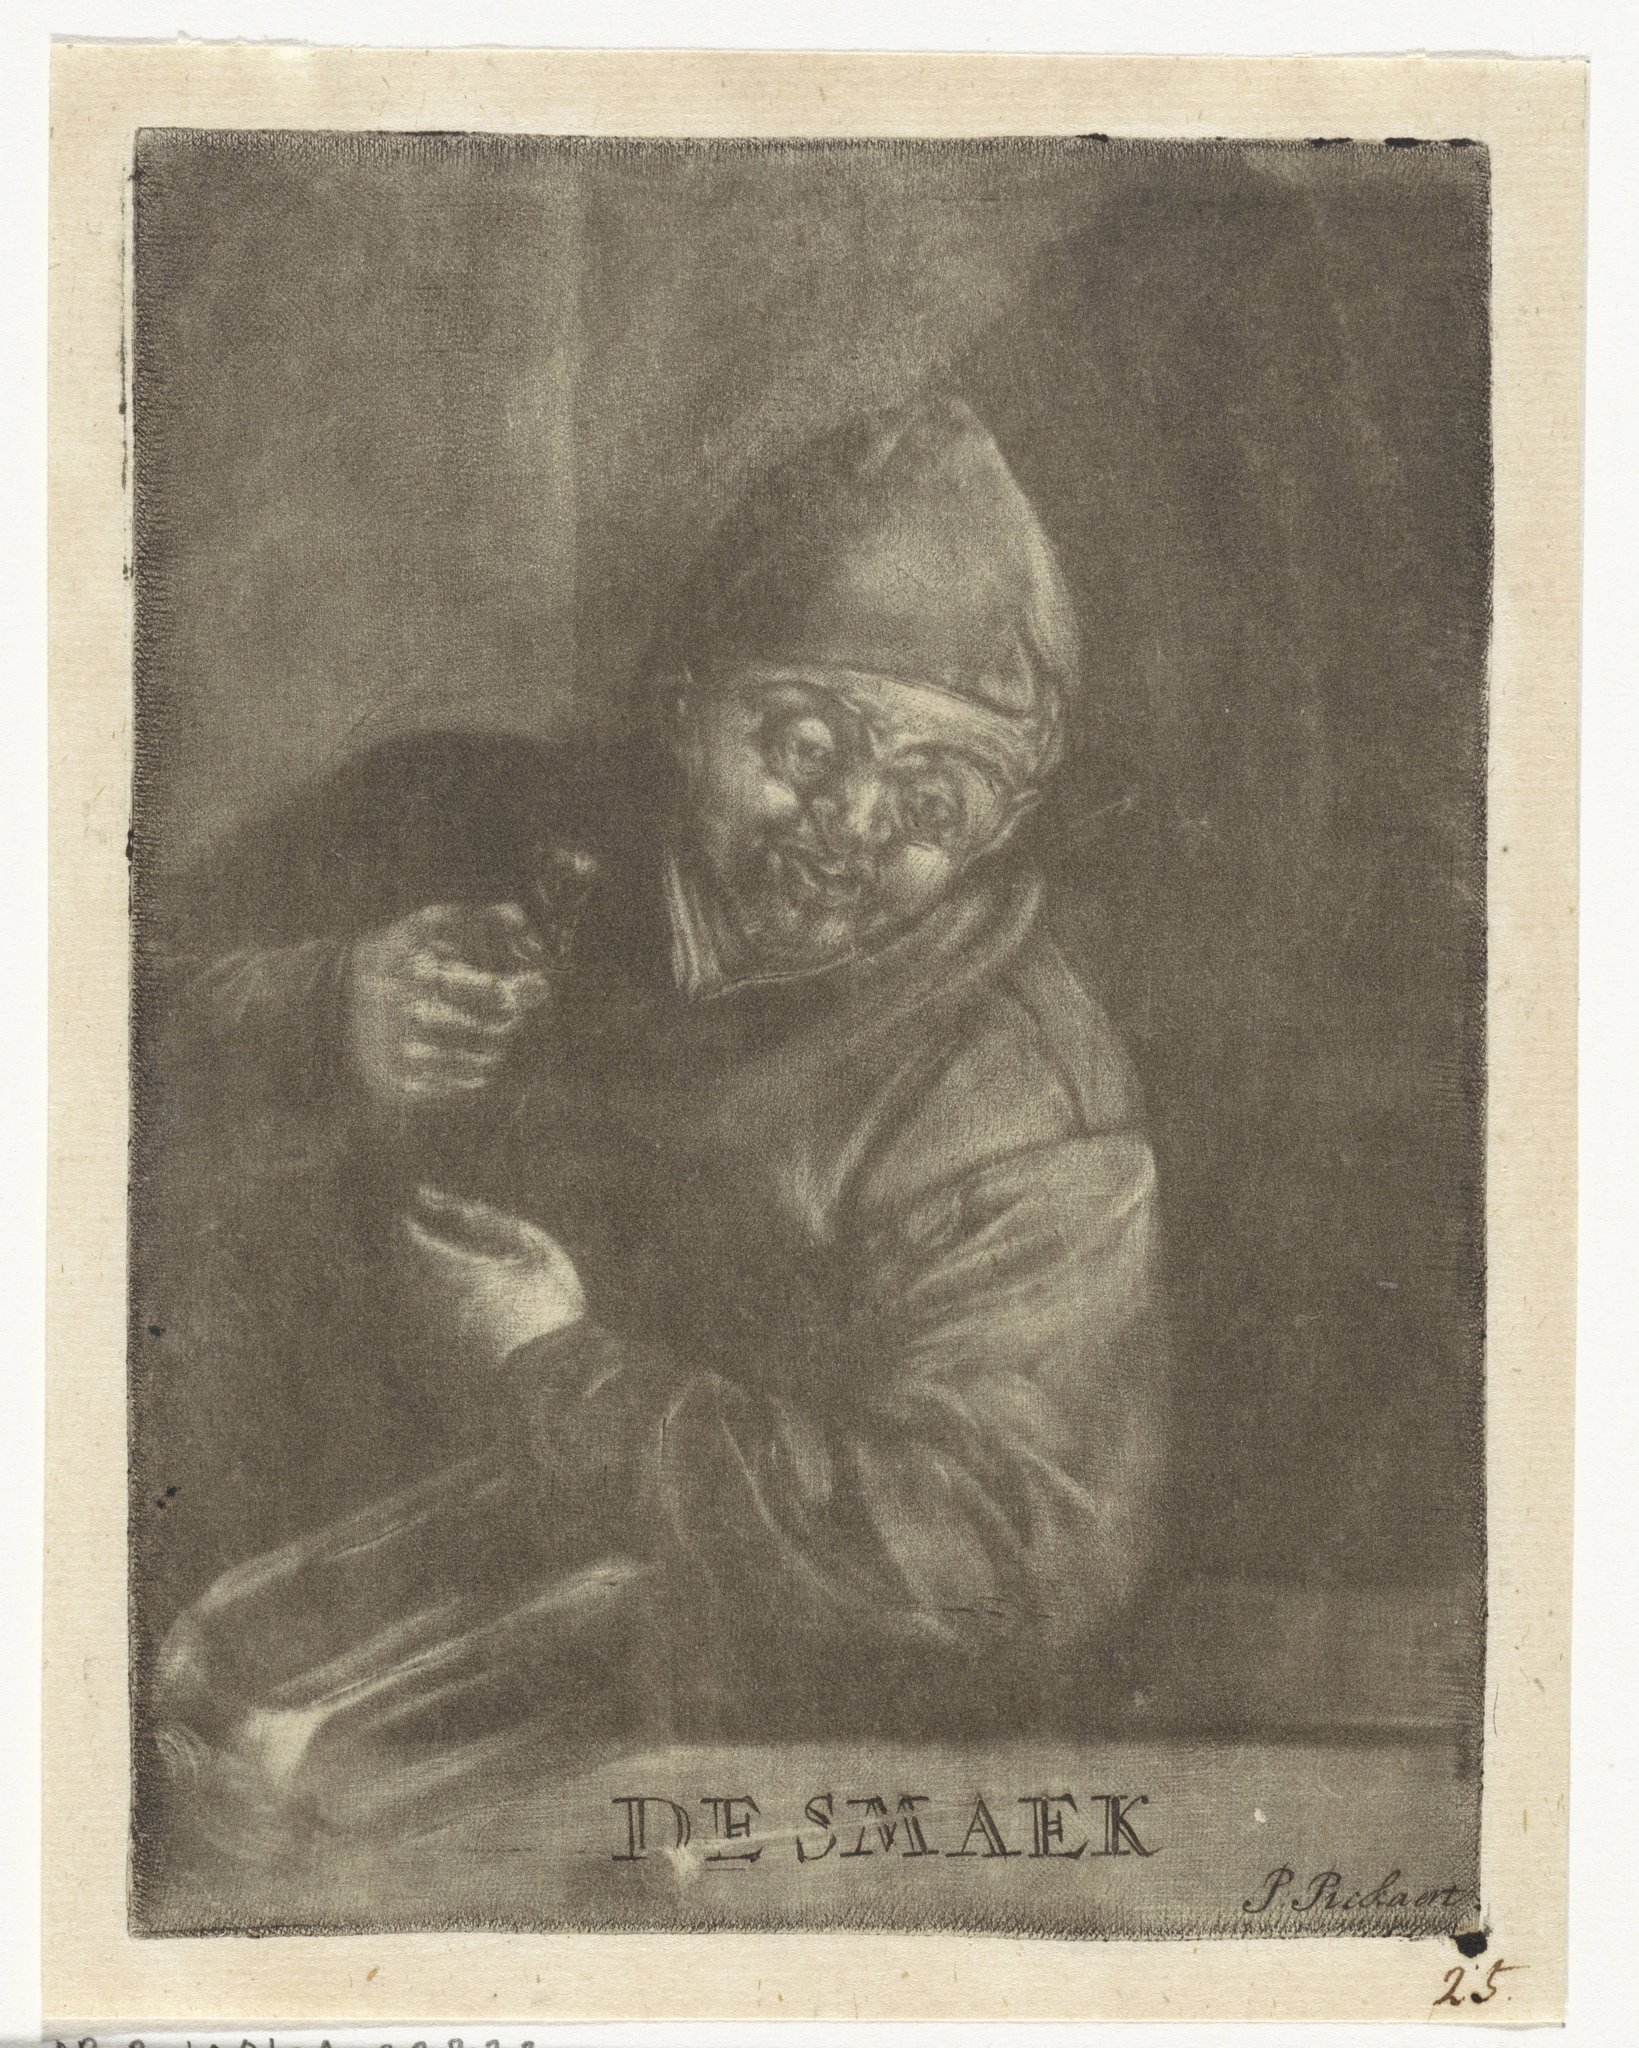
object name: print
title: De smaek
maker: pieter pickaert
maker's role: print maker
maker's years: 1668-1737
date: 1680-1715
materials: paper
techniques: mezzotint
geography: amsterdam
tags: taste, tasting (one of the five senses), glass of wine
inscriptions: collector's mark: Lugt 2228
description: Het zintuig Smaak. Een man met een glaasje in de hand. Voor hem ligt een lege fles.